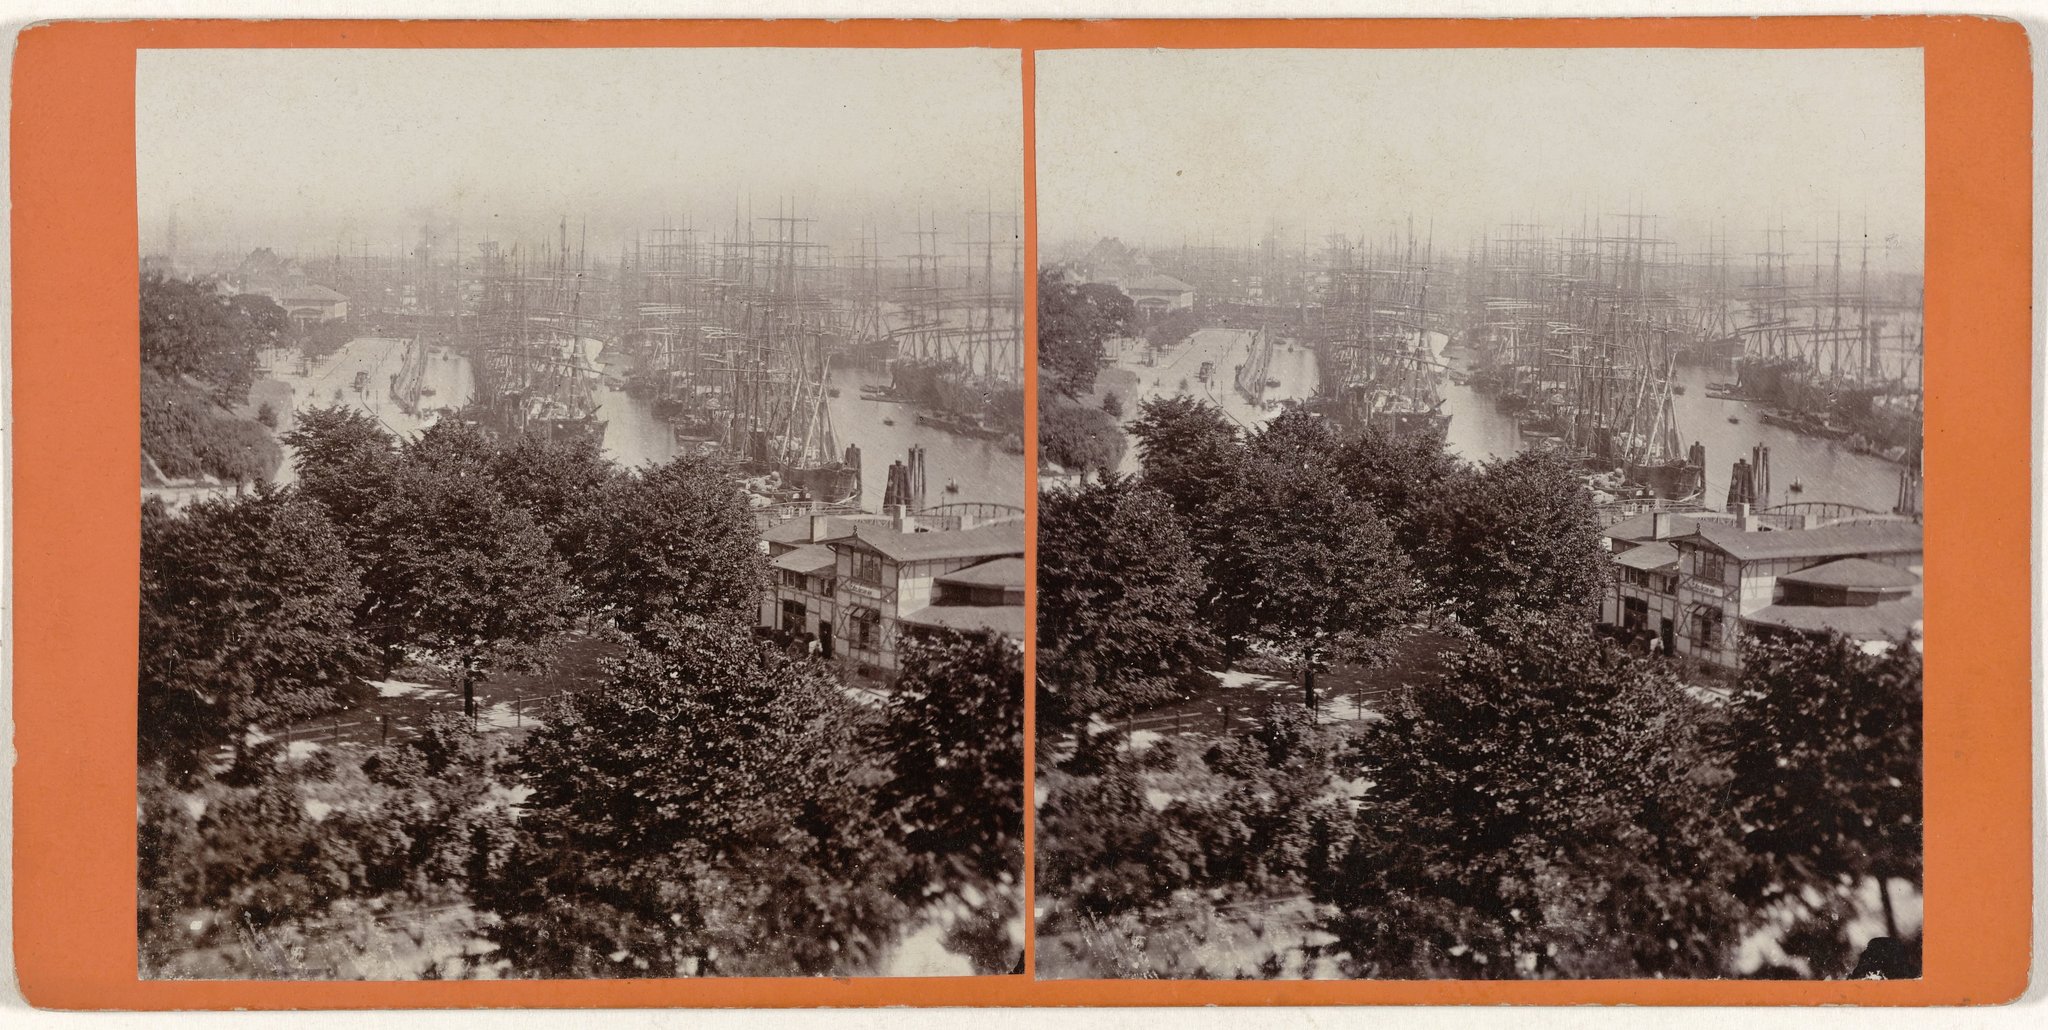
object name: stereograph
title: Gezicht op de haven in Hamburg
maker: Anonymous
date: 1873-1890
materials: cardboard, photographic support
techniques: collodion silver print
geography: hamburg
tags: harbour, ships (in general) - cc - more than one ship